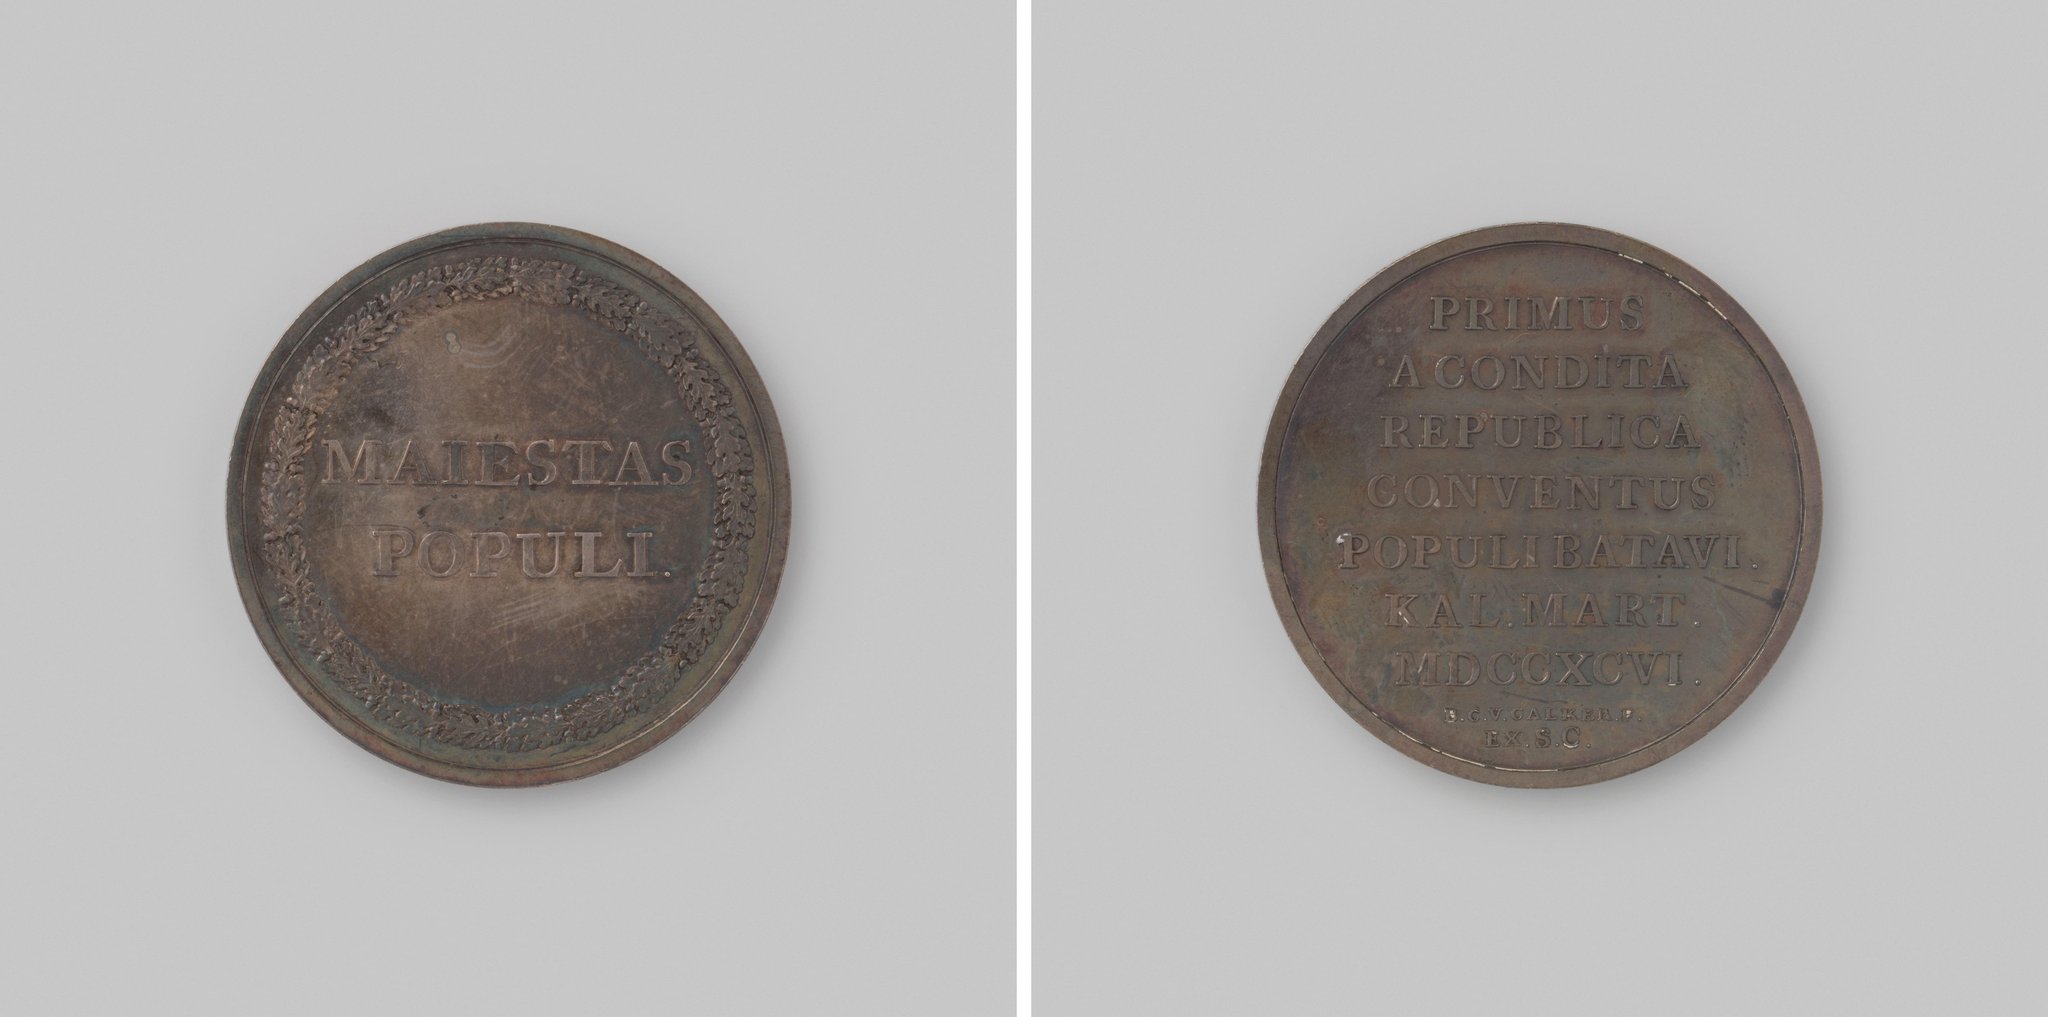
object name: history medal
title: De eerste Nationale Vergadering te 's-Gravenhage 1796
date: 1796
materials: silver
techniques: striking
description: Zilveren penning, op de voorzijde de tekst MAIESTAS POPULI in eikenkrans, op de keerzijde zeven regels tekst.